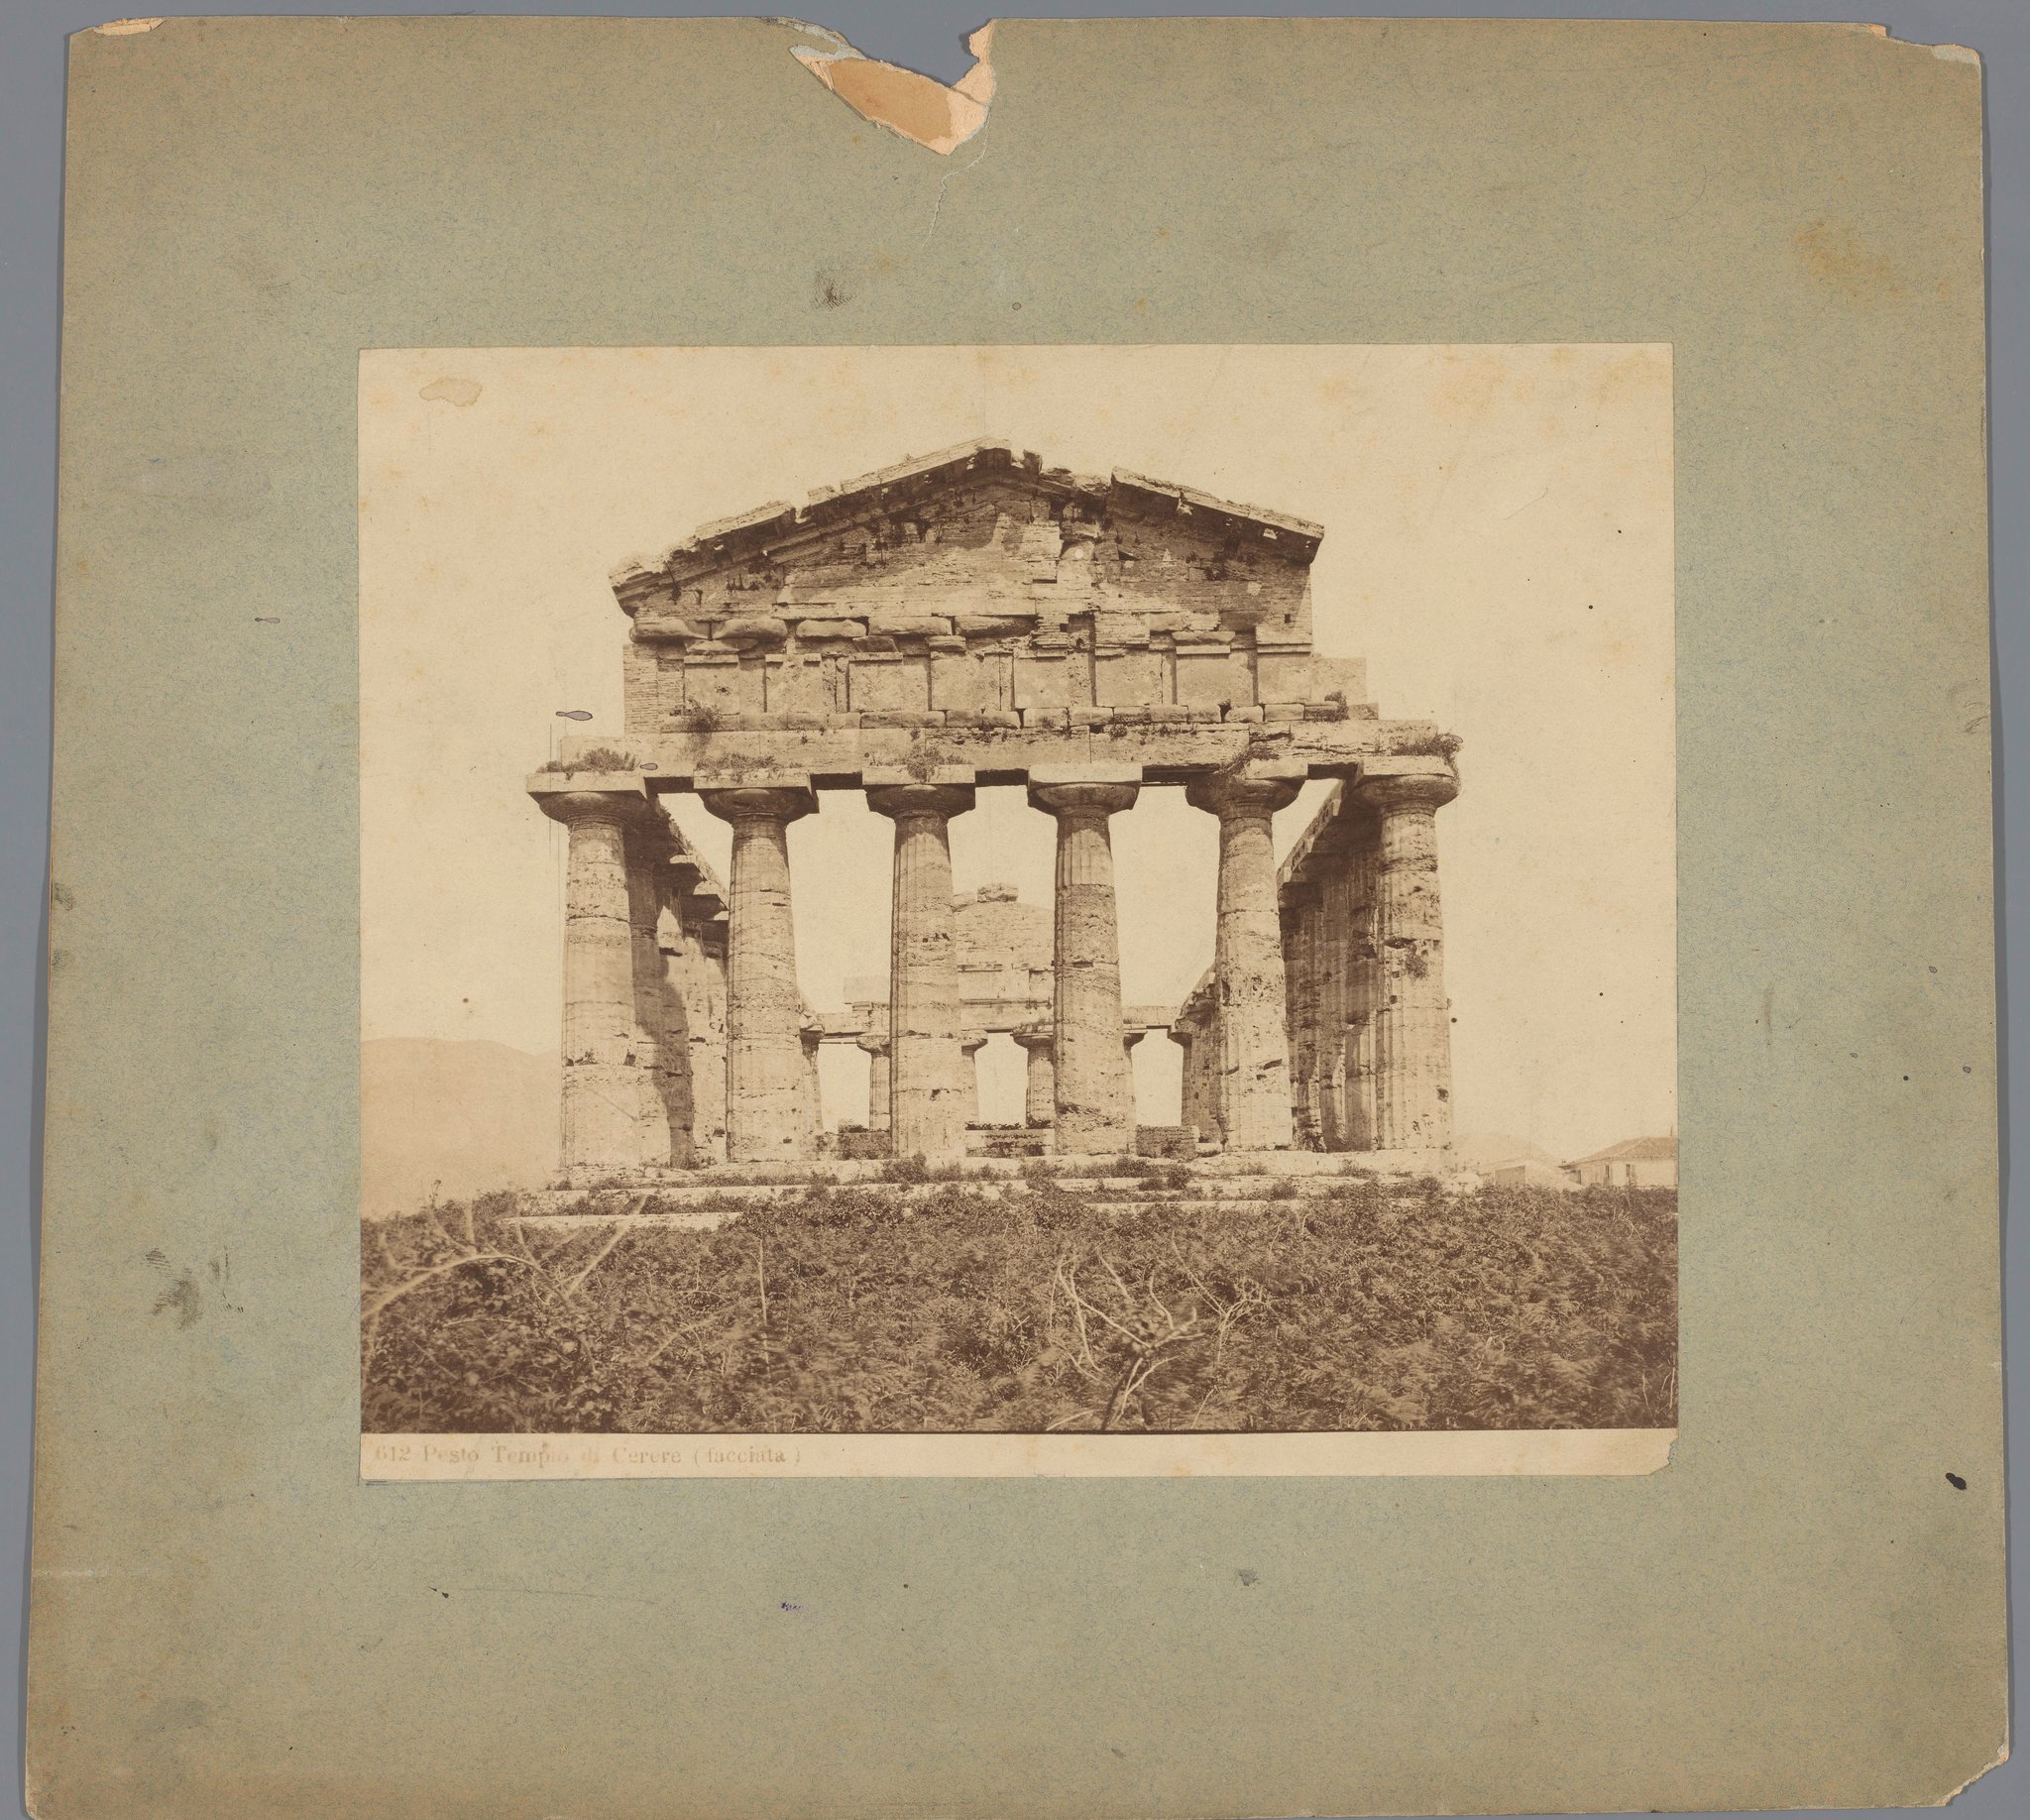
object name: photograph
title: Pesto Templo di Cerere (facciata)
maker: Anonymous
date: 1850-1900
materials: cardboard, photographic support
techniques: albumen print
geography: paestum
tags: landscape with ruins, temple, shrine ~ greek religion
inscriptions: inscription: ‘Pesto. 26/III.1885’, collector's mark: ‘Rijks Opleidingsinstituut/ voor Teekenleeraren/ vrb hooger; middelb:/ & nijverheidsonderwijs/ Rijksmuseum/ Amsterdam’, number: ‘612’